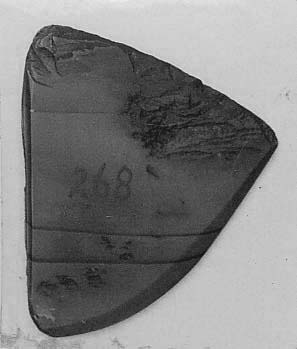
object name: knife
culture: north american, alaskan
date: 1902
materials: jade